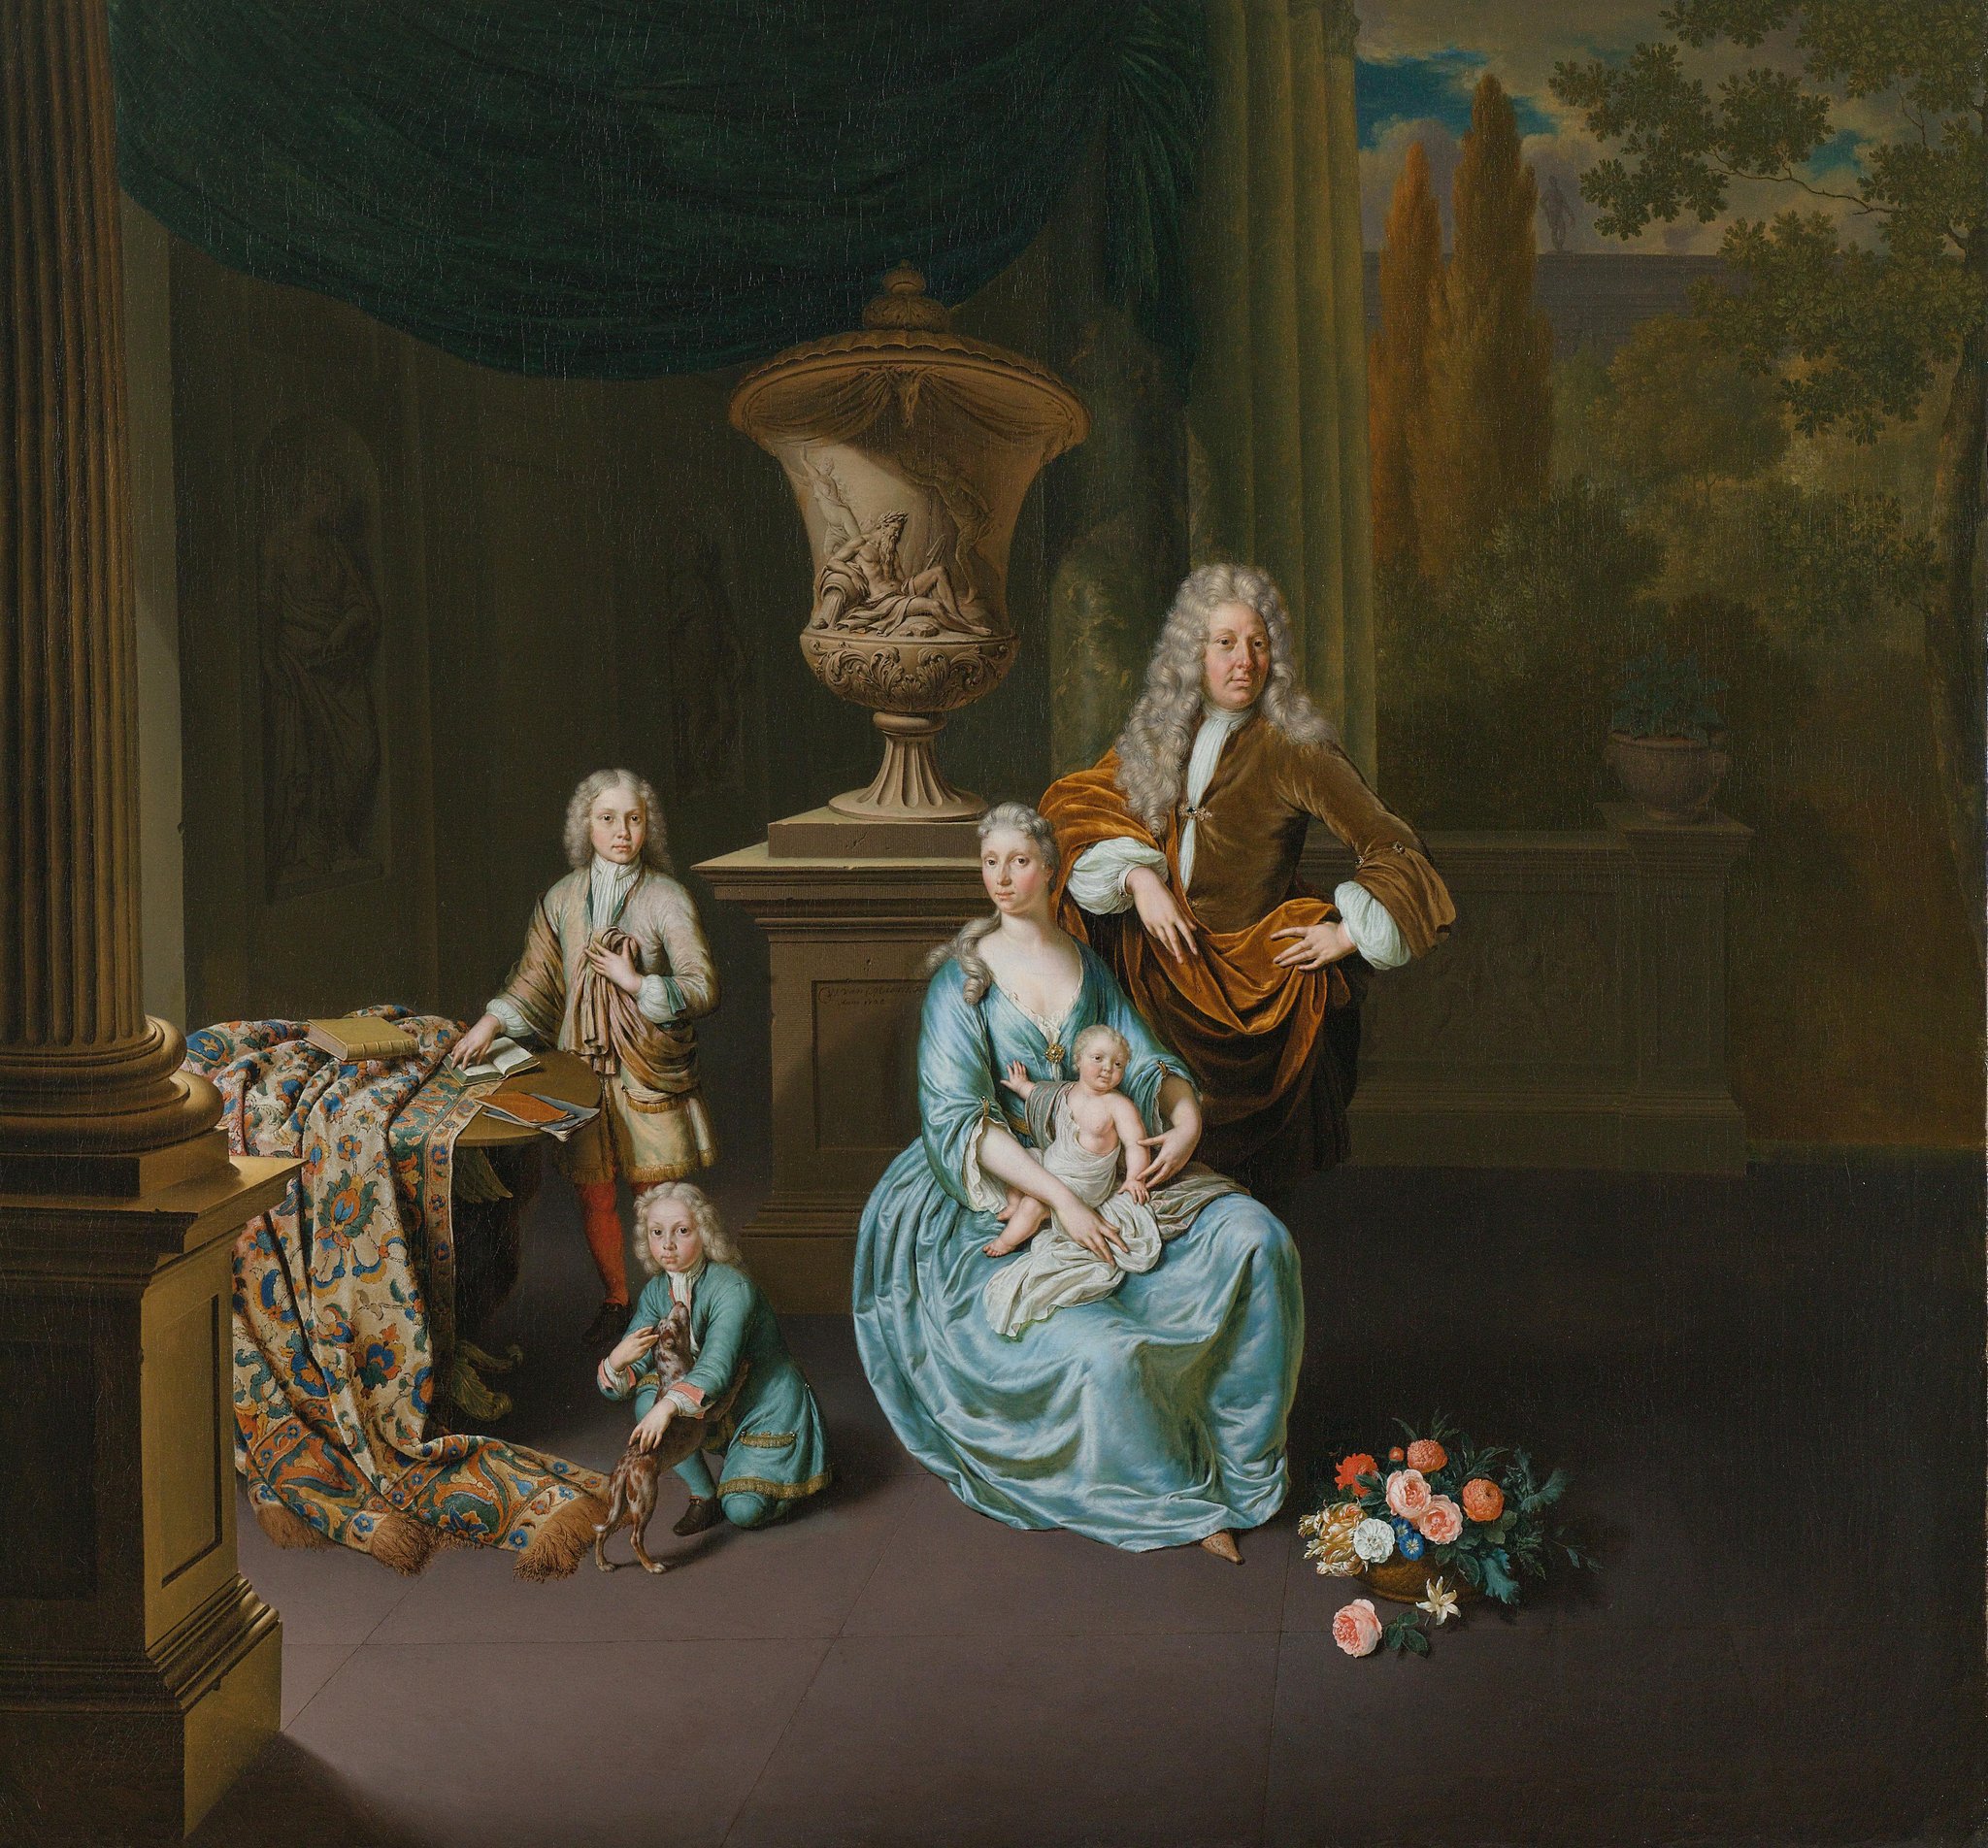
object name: painting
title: Portrait of Diederik, Baron van Leyden van Vlaardingen with his Wife and three Sons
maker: willem van mieris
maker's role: draughtsman, painter, print maker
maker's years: 1662-1747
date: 1728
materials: canvas, oil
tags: diderik van leyden, sophia dina de rovere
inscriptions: signature and date: ‘W. van Mieris Fe.c Anno 1728’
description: Familieportret van Diederik baron van Leyden van Vlaardingen met zijn vrouw Sophia Dina de Rovere en hun drie zonen Pieter, Jan en Adriaan Pompejus. Het gezin bevindt zich in een interieur met links een tafel waarop enkele boeken liggen, Jan speelt met een hond. Op de vloer staat een boeket bloemen. Op de achtergrond een tuinvaas met een riviergod, rechts een doorkijk naar de tuin. De prentverzameling van Pieter Cornelis van Leyden werd in 1806 door koning Lodewijk Napoleon aangekocht en vormt de basis voor de collectie van het Rijksprentenkabinet.